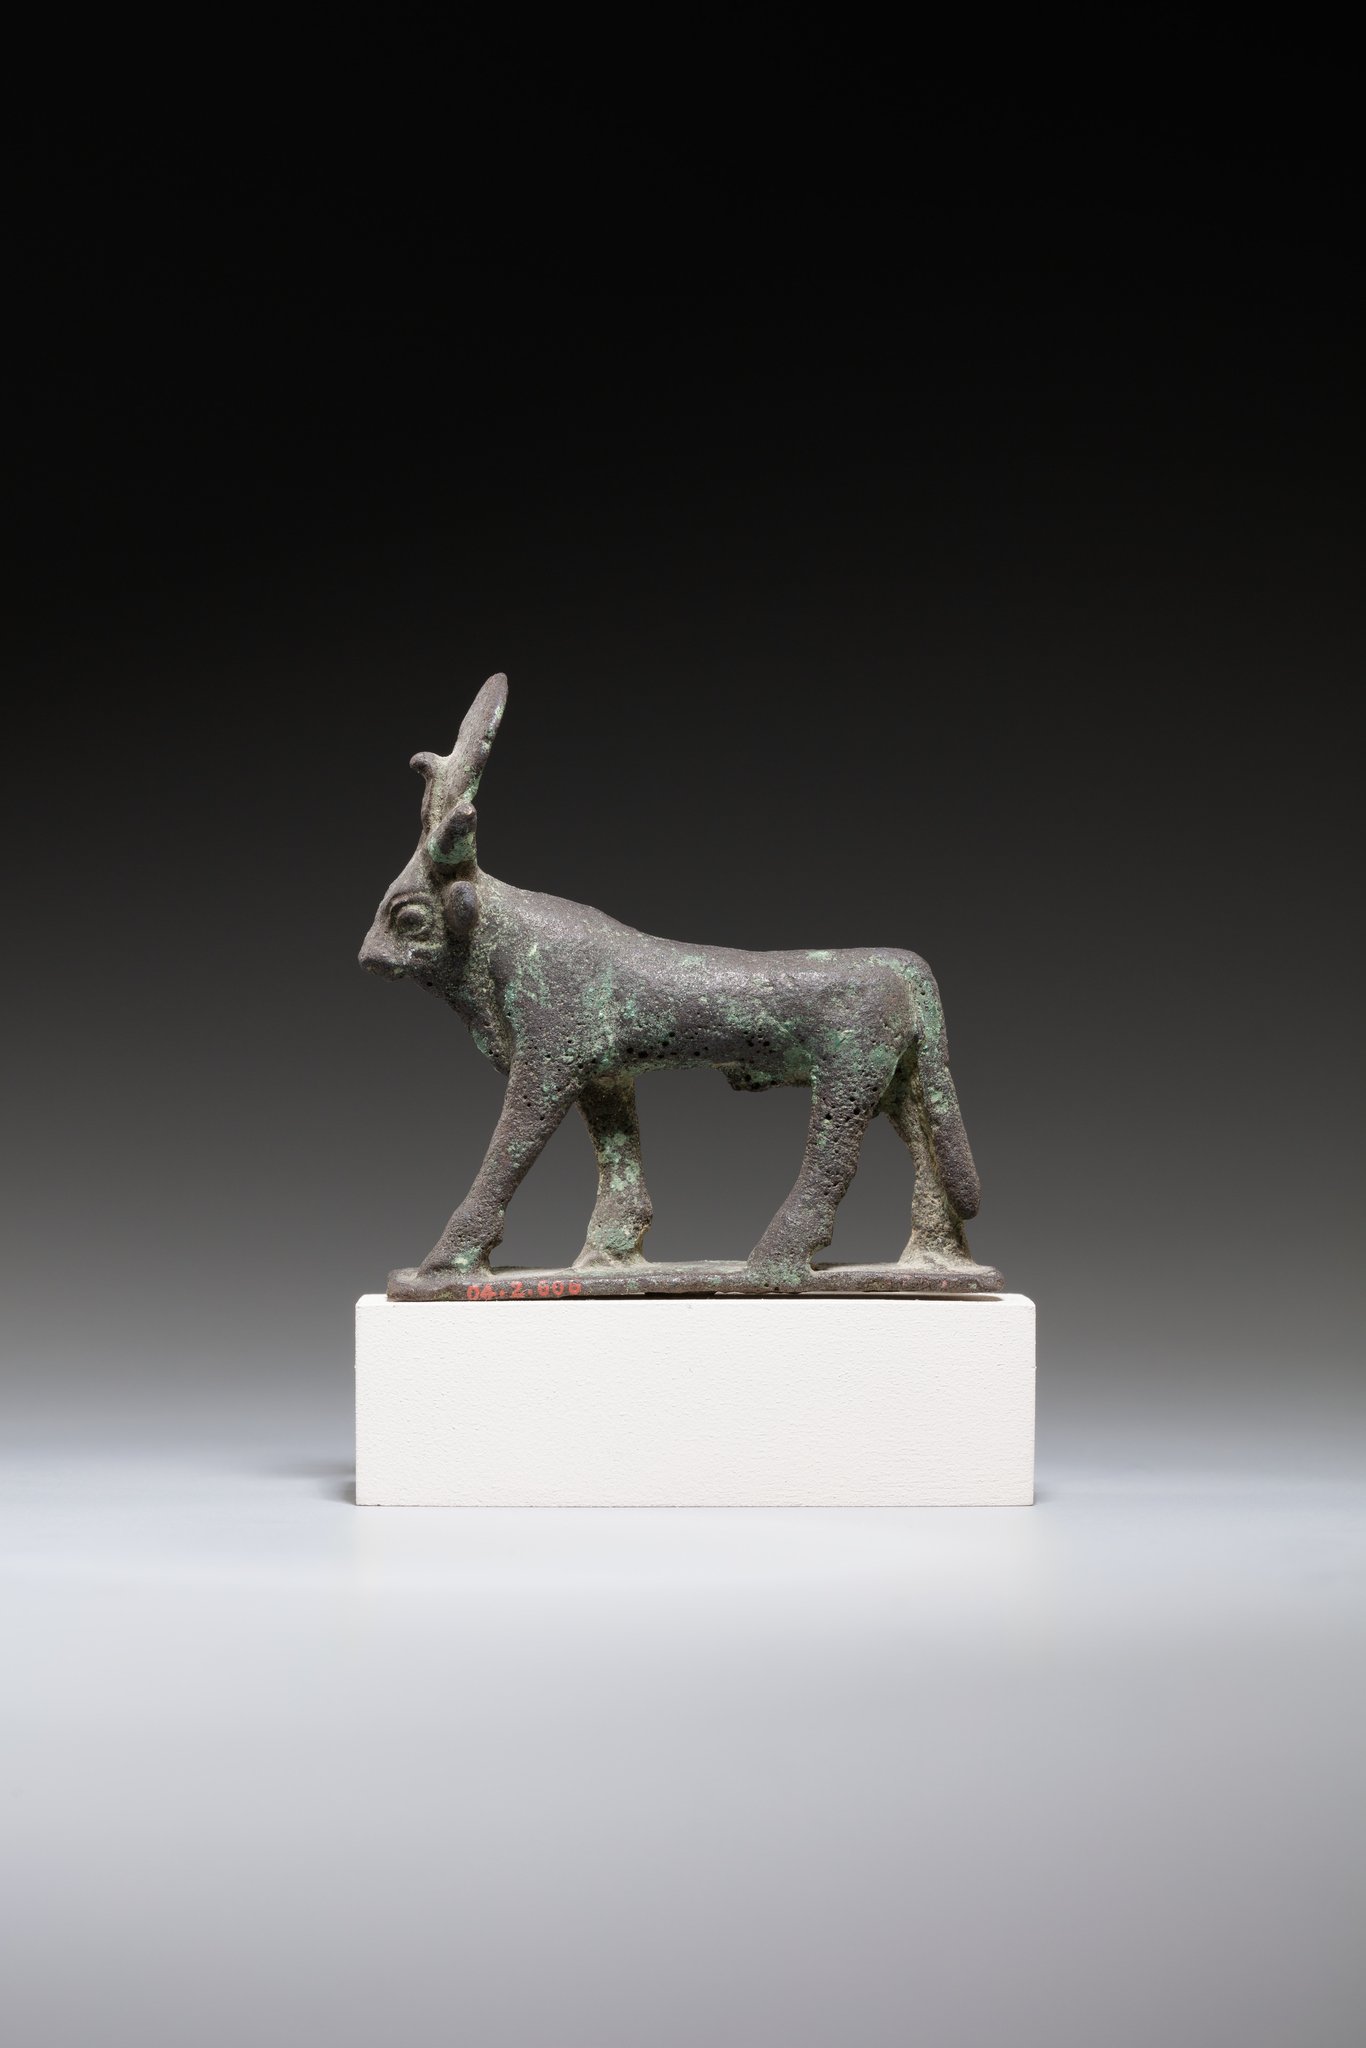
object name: figurine, bull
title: Bull figurine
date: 664-332 BCE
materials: bronze, copper alloy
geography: egypt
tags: bulls